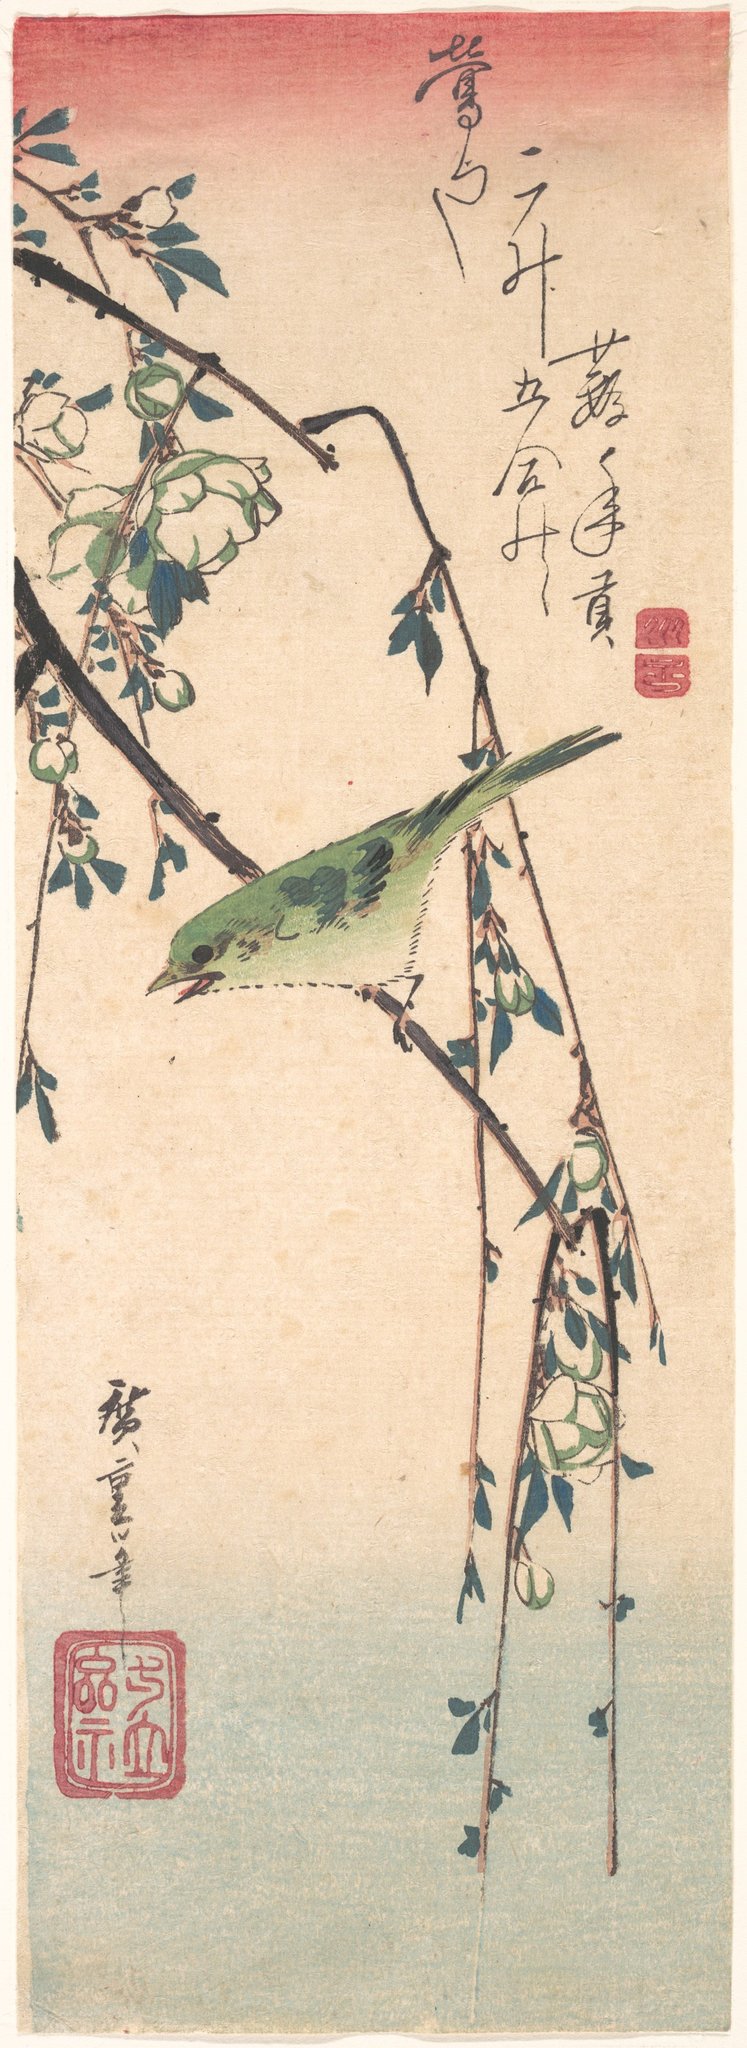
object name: woodblock print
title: Warbler on a Plum Branch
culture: japanese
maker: utagawa hiroshige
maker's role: artist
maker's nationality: japanese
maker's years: 1797-1858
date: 1835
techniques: woodblock print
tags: birds